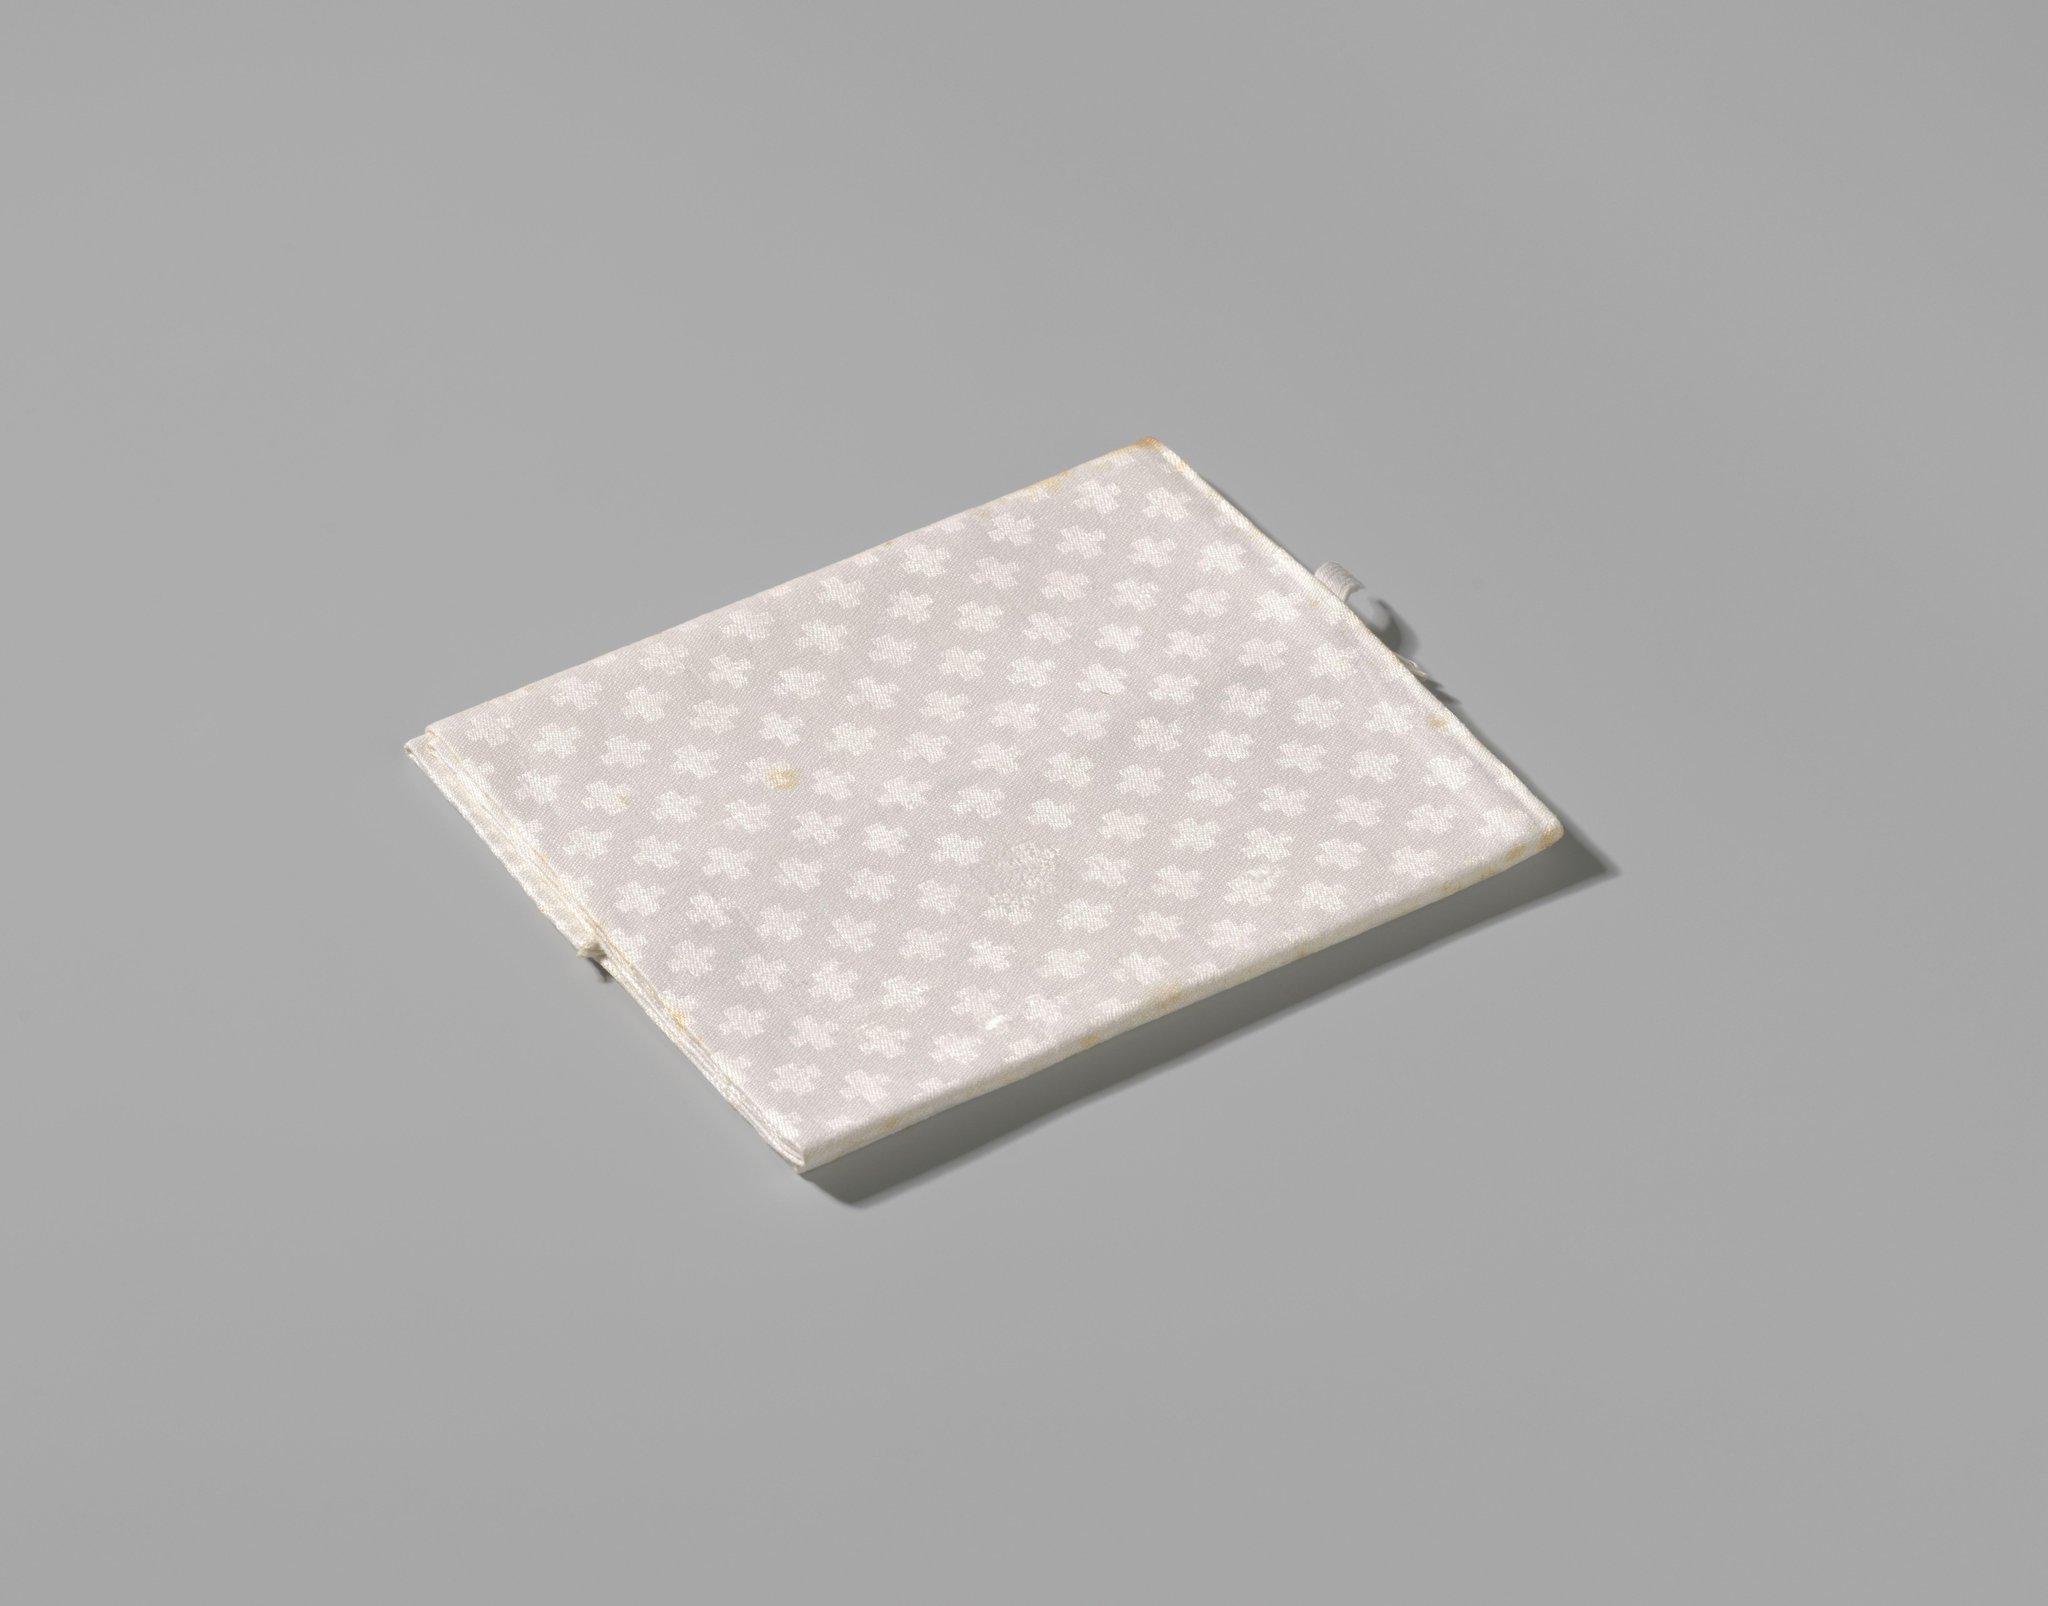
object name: towel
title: Handdoek van linnen pellendamast.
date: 1800-1899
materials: linen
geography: netherlands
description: Linnen handdoek van pellendamast. Het patroon heeft verspringende rijen kruisen en gestreepte randen. De handdoek heeft twee aangenaaide lussen.